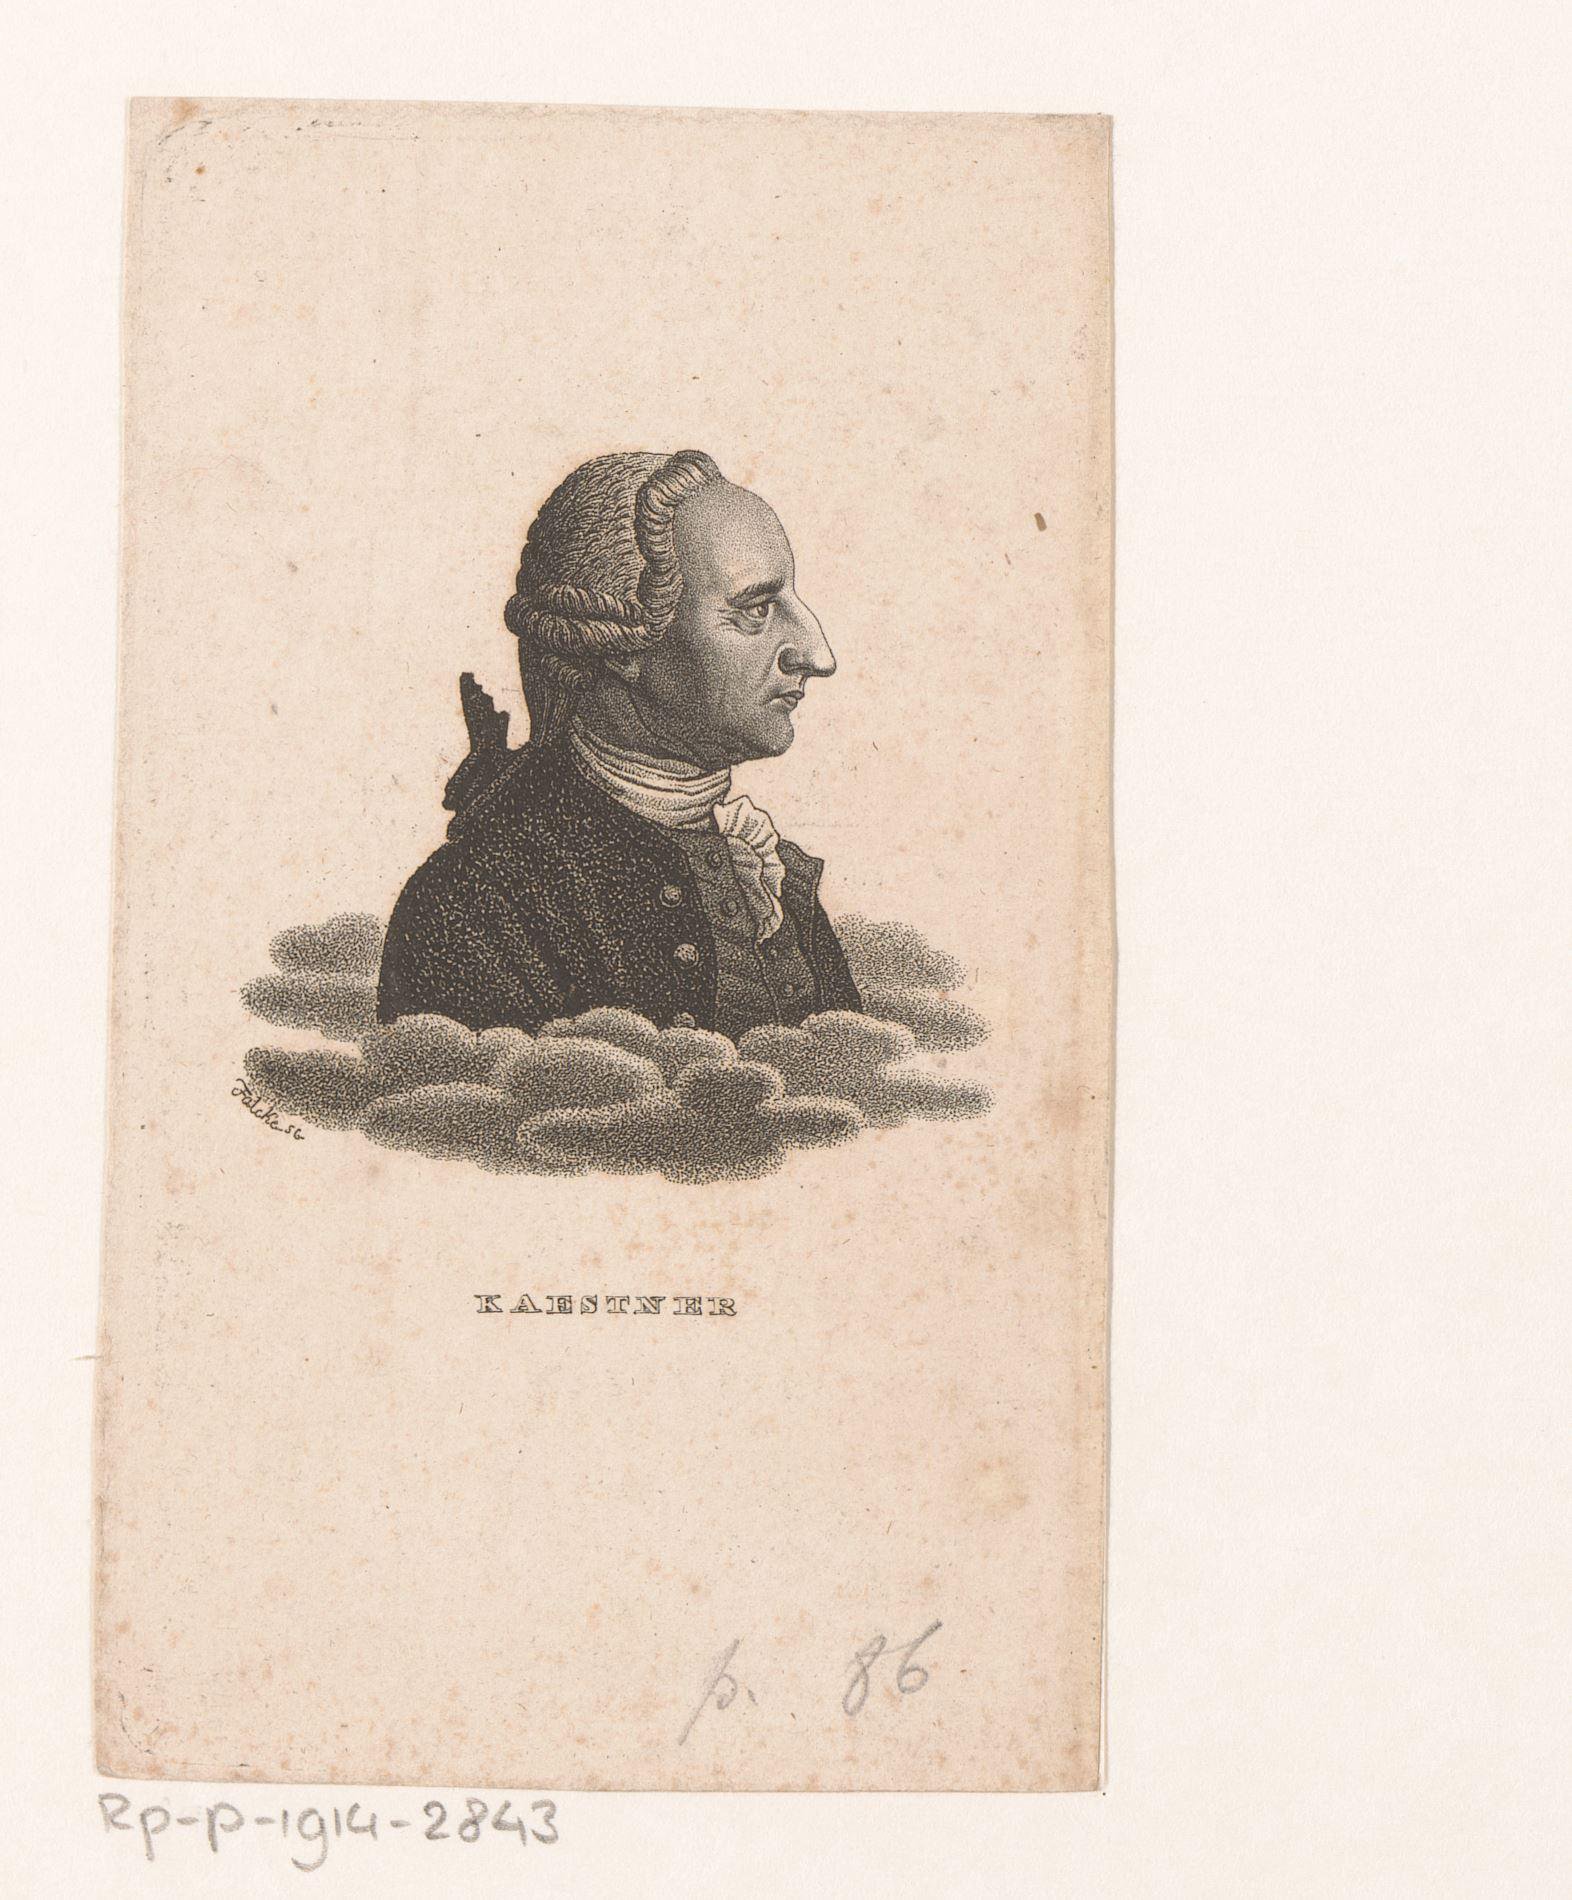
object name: print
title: Portret van Abraham Gotthelf Kaestner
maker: tobias falke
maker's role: print maker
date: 1800-1830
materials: paper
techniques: stippling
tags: clouds, historical persons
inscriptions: collector's mark: Lugt 2228